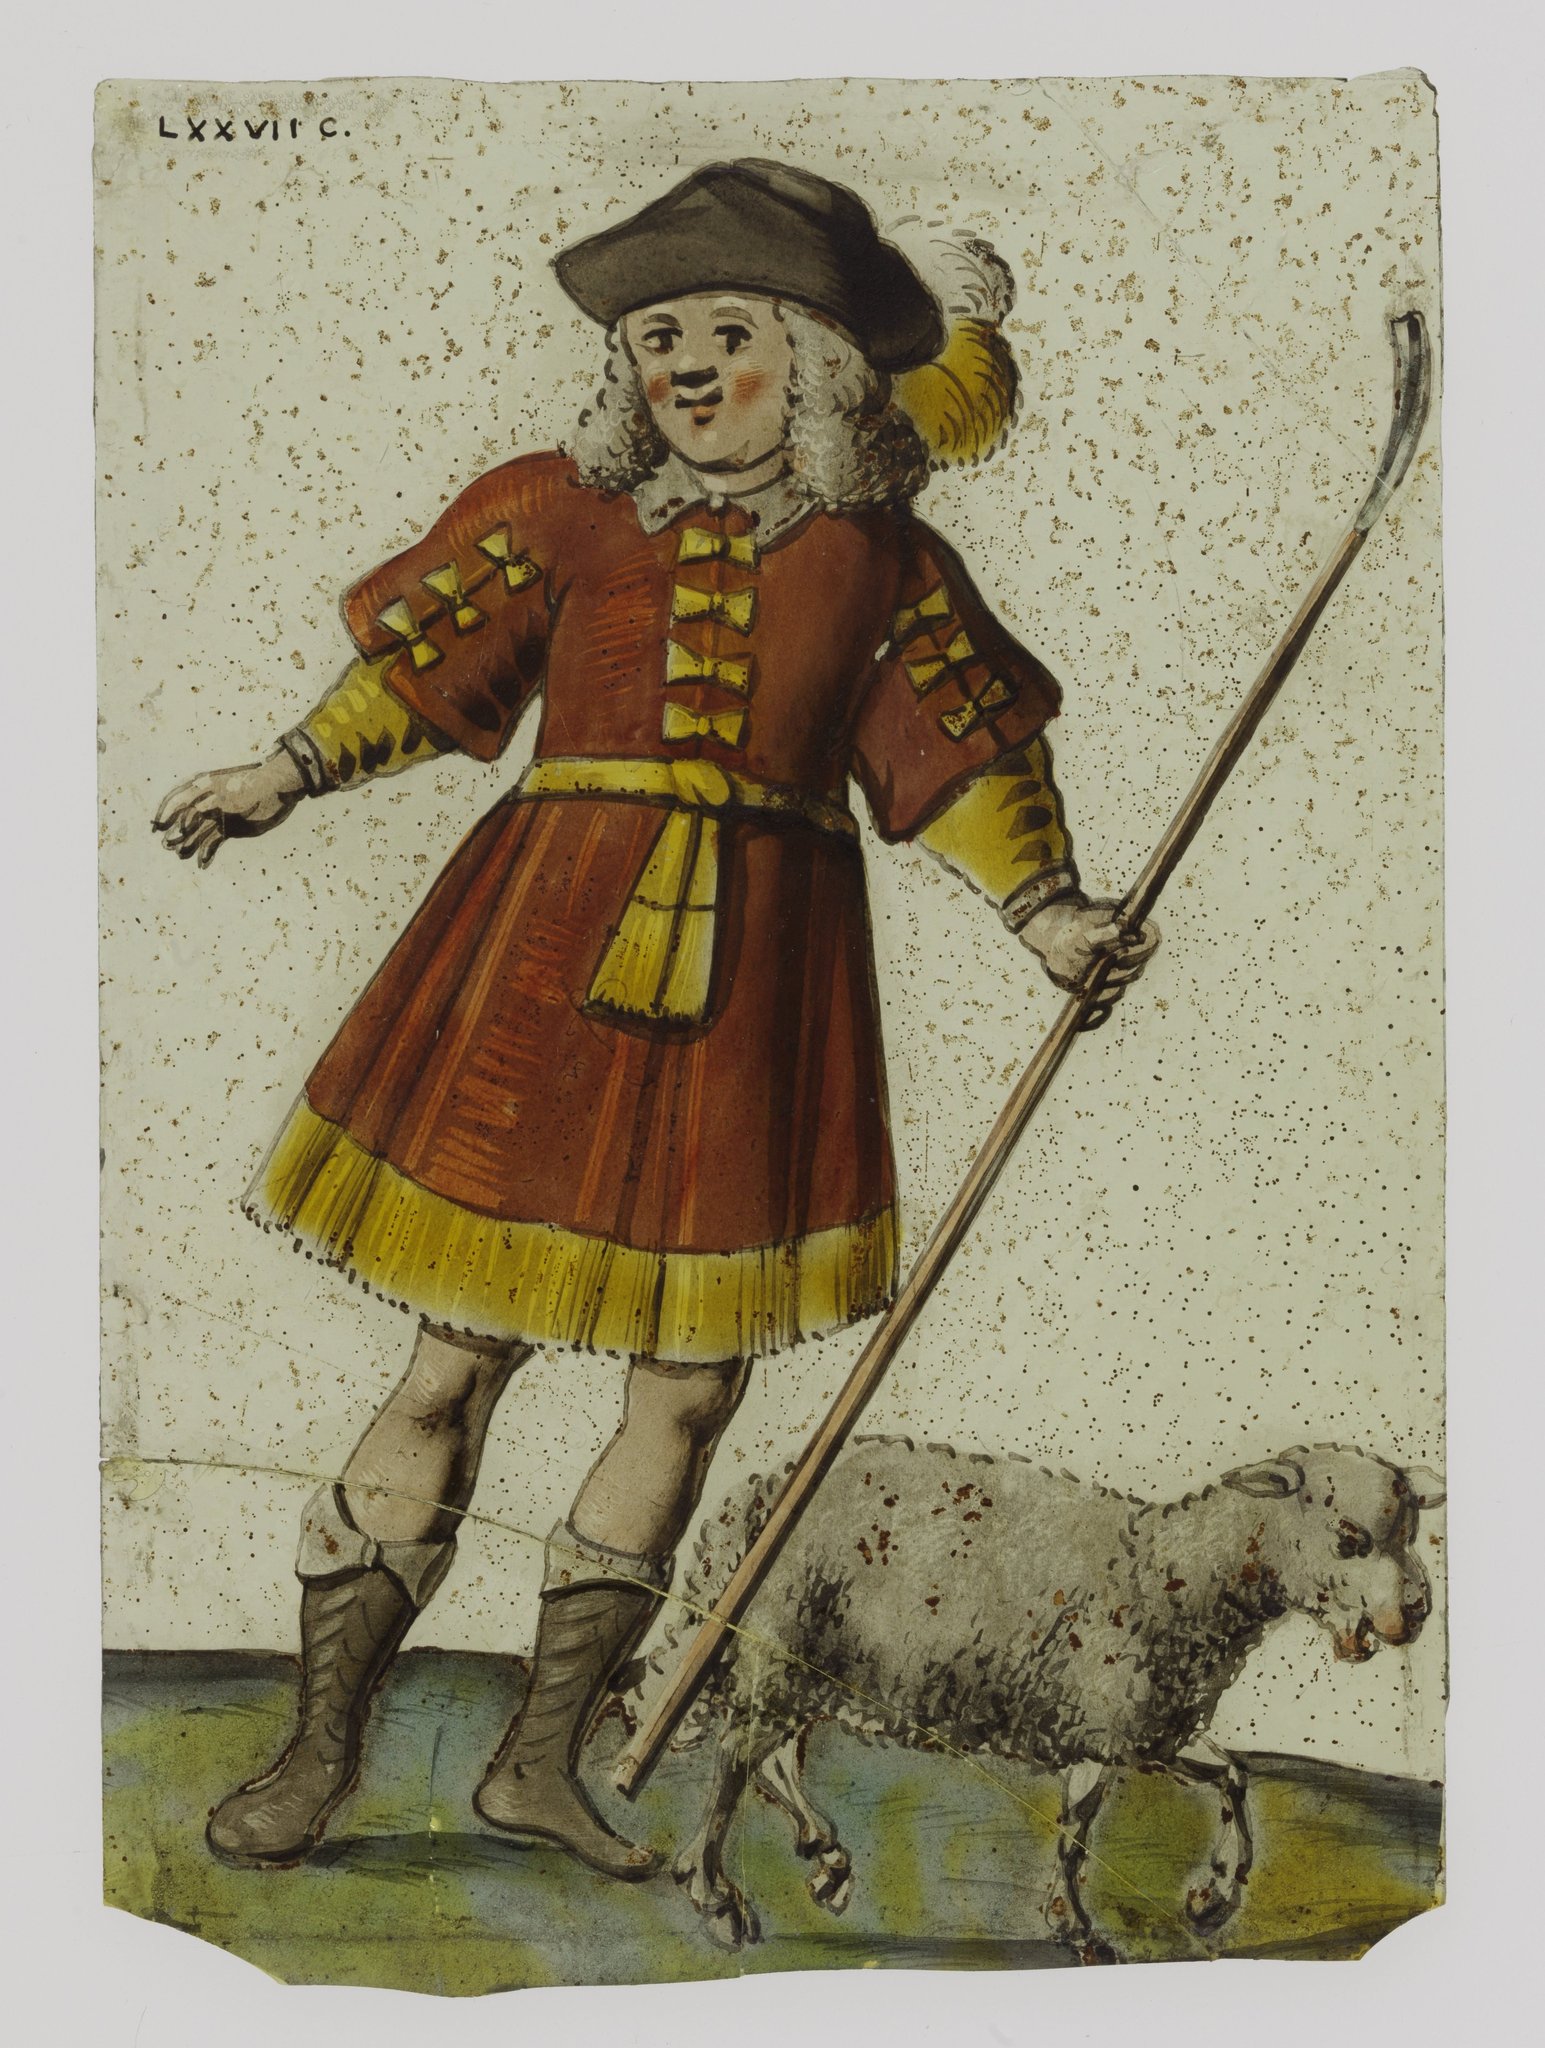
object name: light window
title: Ruit met een herder met een staf en een schaap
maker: Anonymous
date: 1650-1675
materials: glass, lead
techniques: enamel painting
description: Ruit met emailschildering van een herder met een staf en een schaap. Opmerking: Onderdeel van de groep LXXVII A t/m I, K en L.